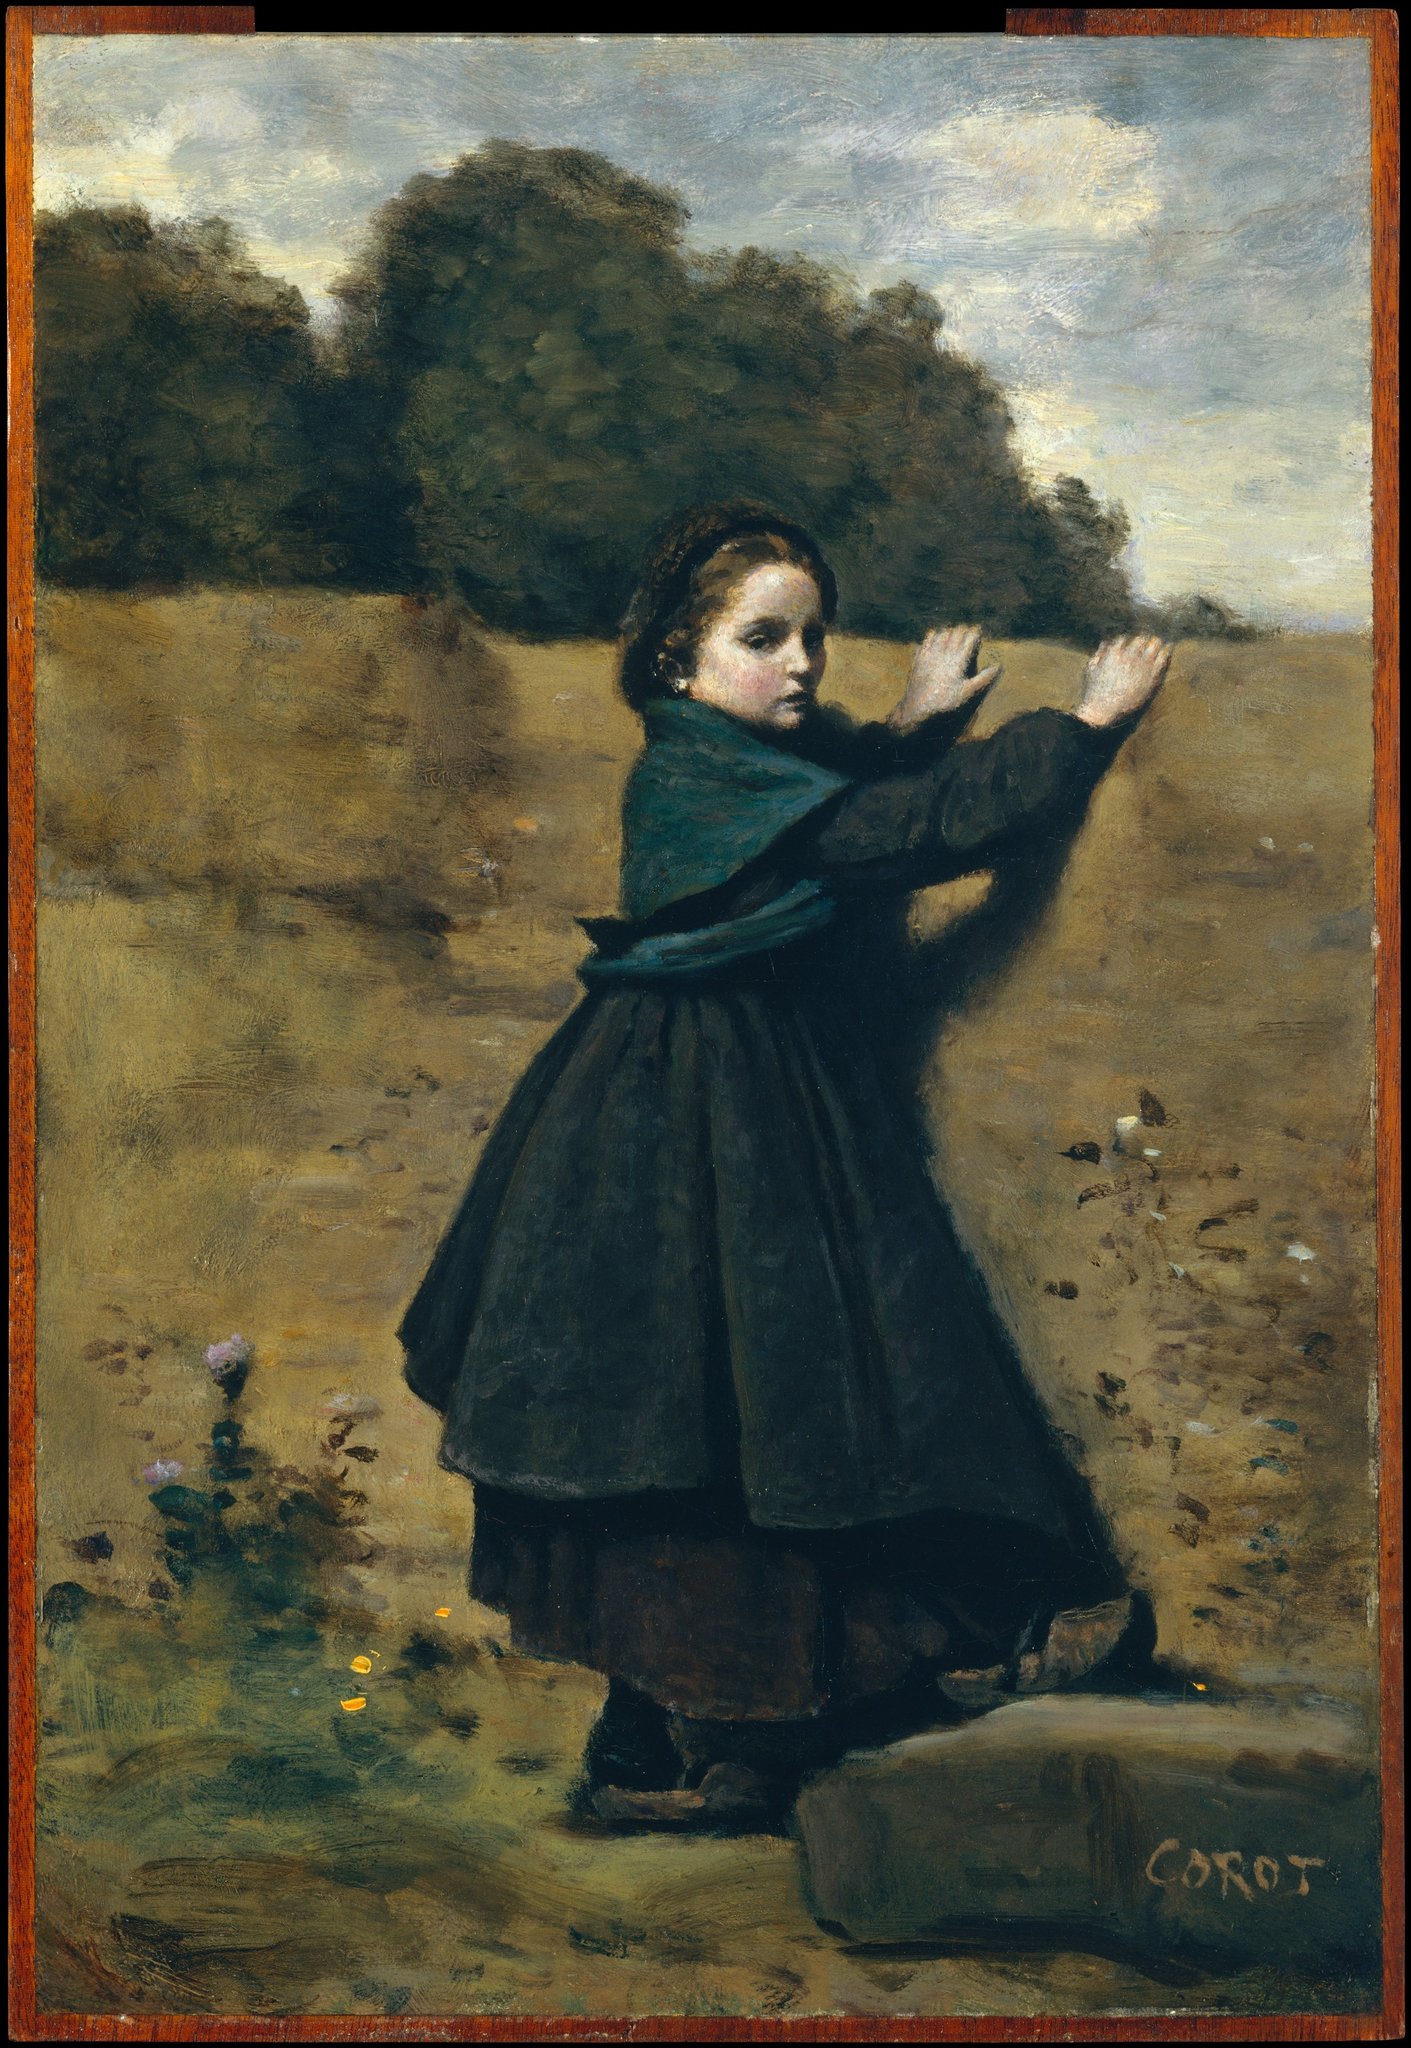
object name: painting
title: The Curious Little Girl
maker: jean-baptiste-camille corot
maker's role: artist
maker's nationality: french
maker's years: 1796-1875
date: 1860-1864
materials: cardboard, oil, wood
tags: girls